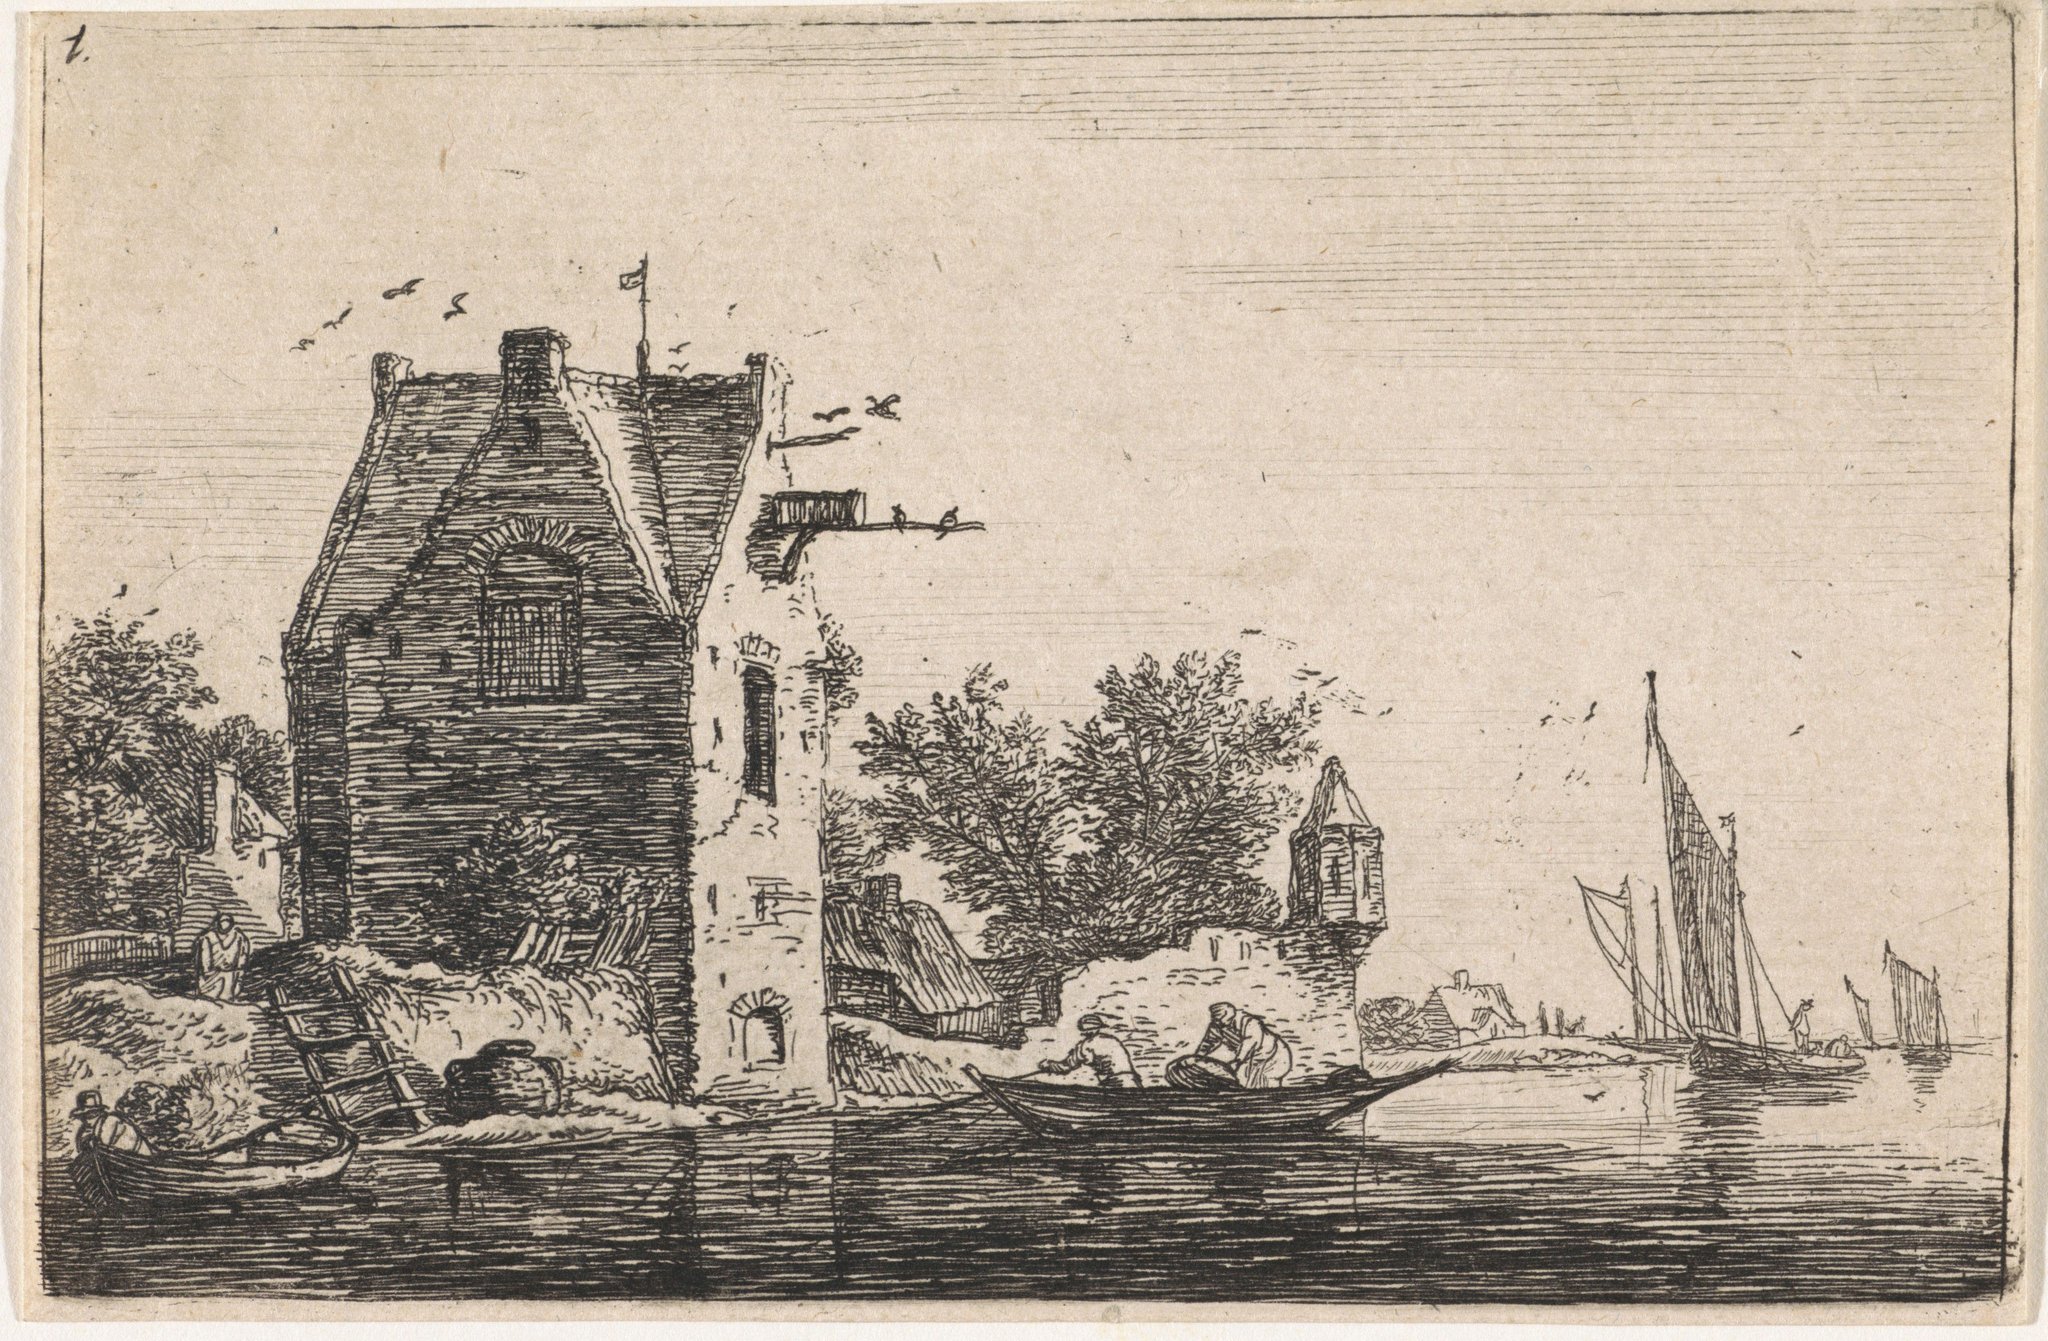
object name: print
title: Landschappen met figuren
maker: anthonie waterloo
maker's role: draughtsman, painter, print maker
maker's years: 1609-1690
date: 1630-1663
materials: paper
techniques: etching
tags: sentry box, sailing-ship, sailing-boat, landscapes with waters, waterscapes, seascapes (in the temperate zone), rowing-boat, canoe, etc., city-walls, landscapes (+ landscape with figures, staffage)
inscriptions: collector's mark: Lugt 2228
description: Een hoog gebouw ligt aan het water. Rechts van het gebouw ligt een deel van de stadsmuur met een wachthuisje. In het water boten. Linksboven is de letter l te zien.